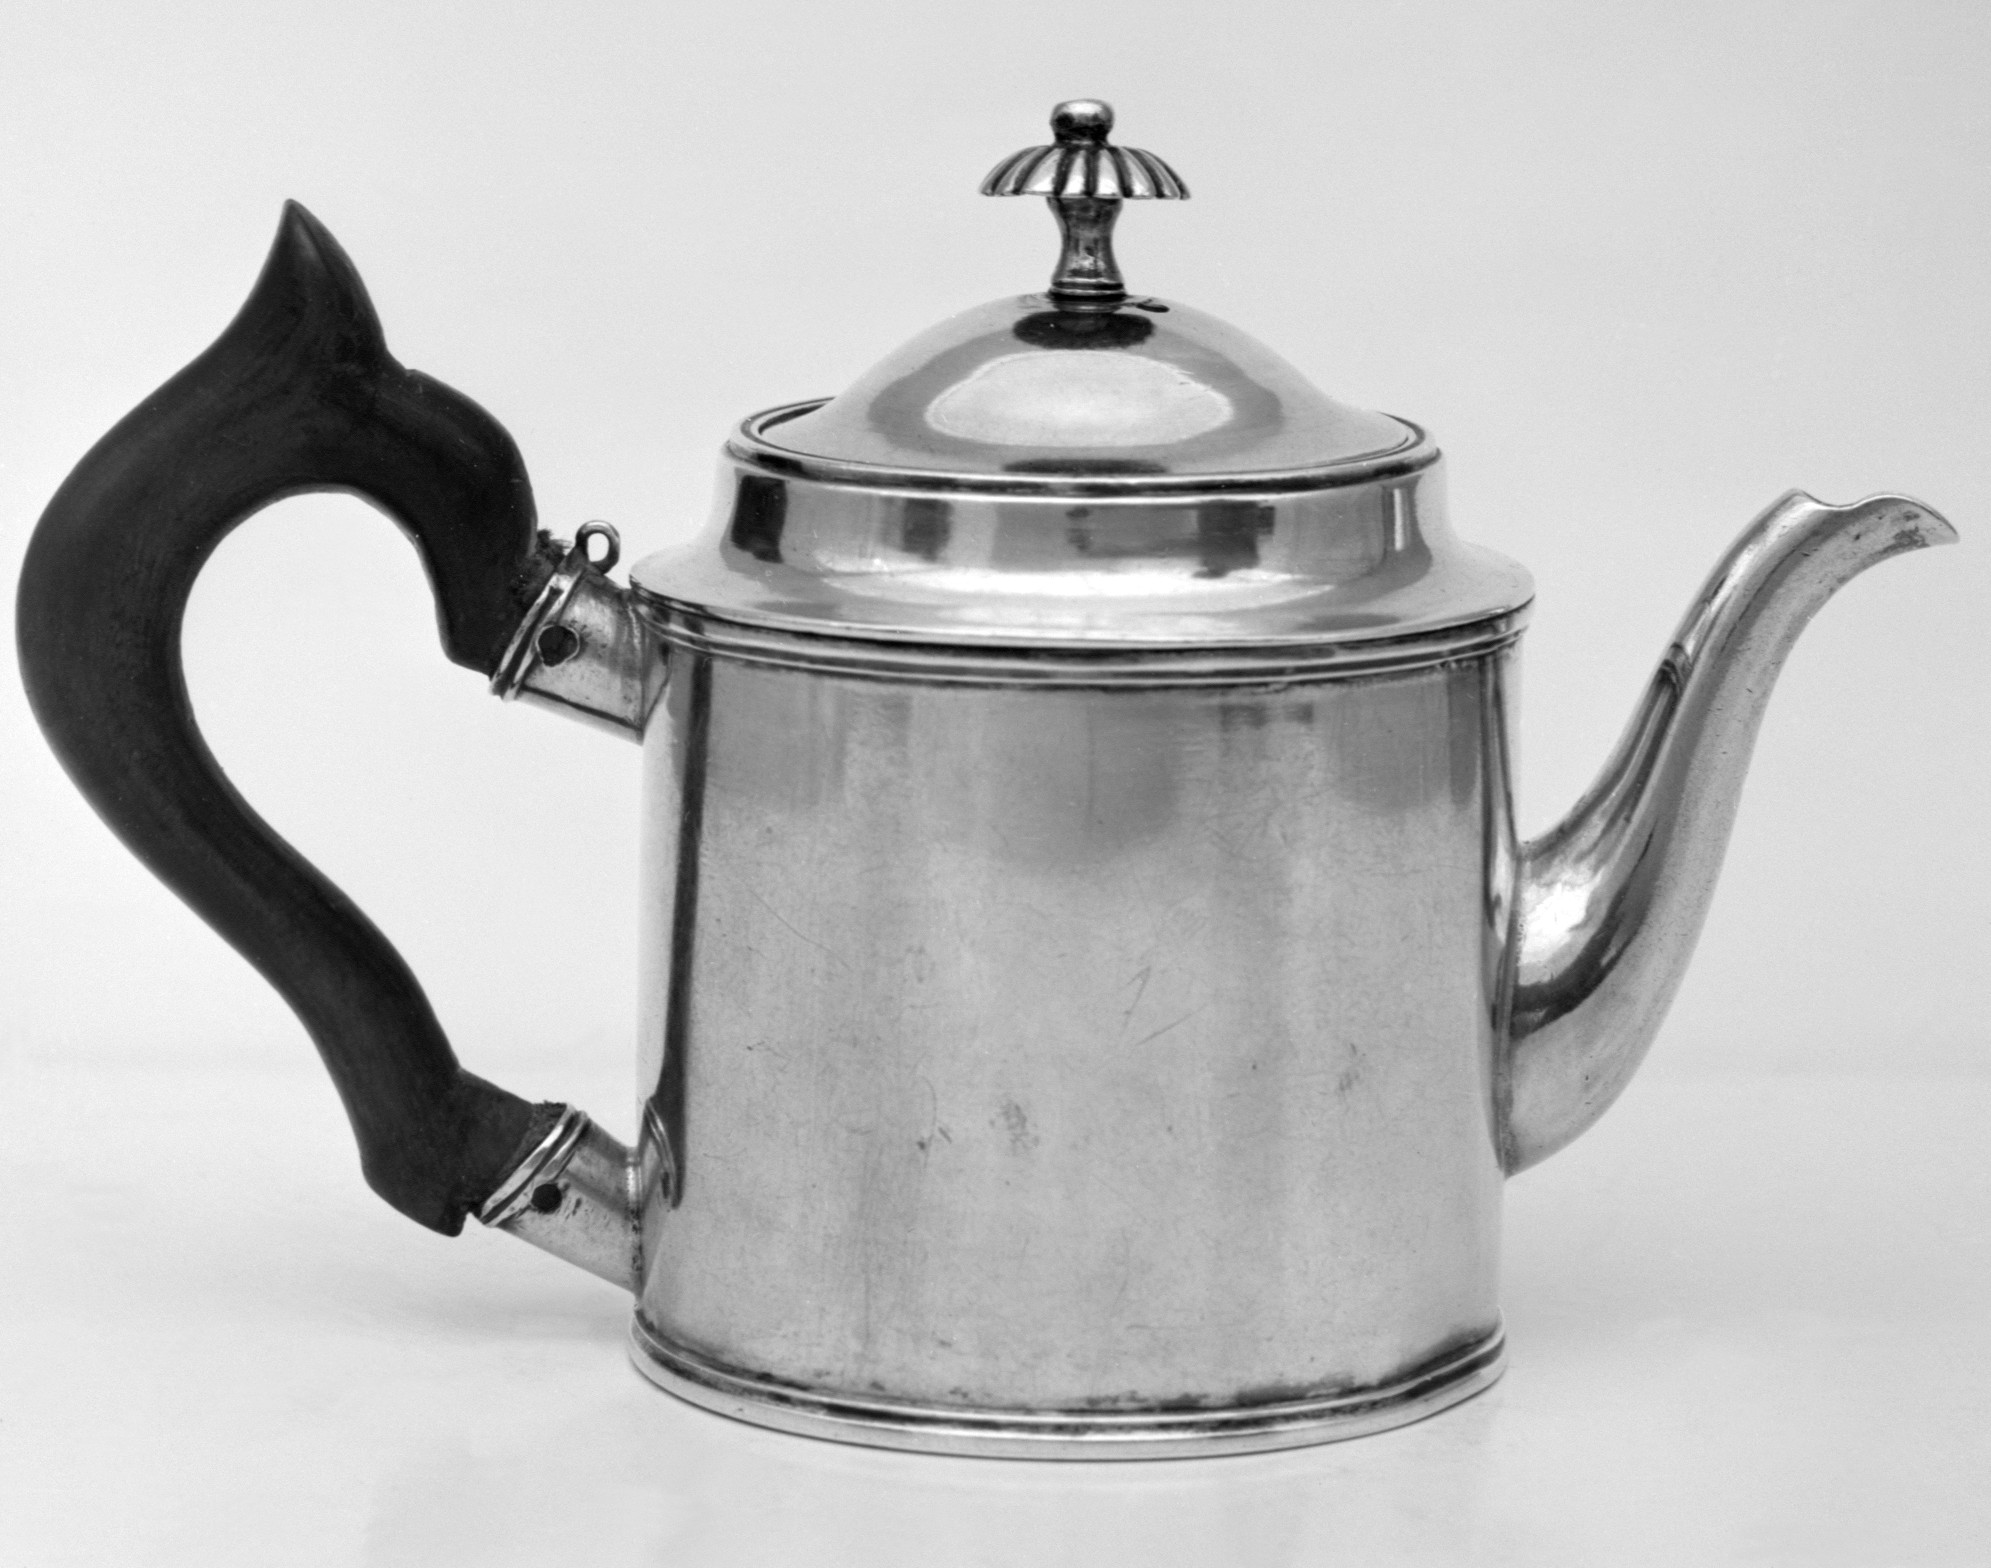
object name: teapot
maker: axel hedlund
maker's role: maker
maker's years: 1799-1839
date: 1801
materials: silver, wood